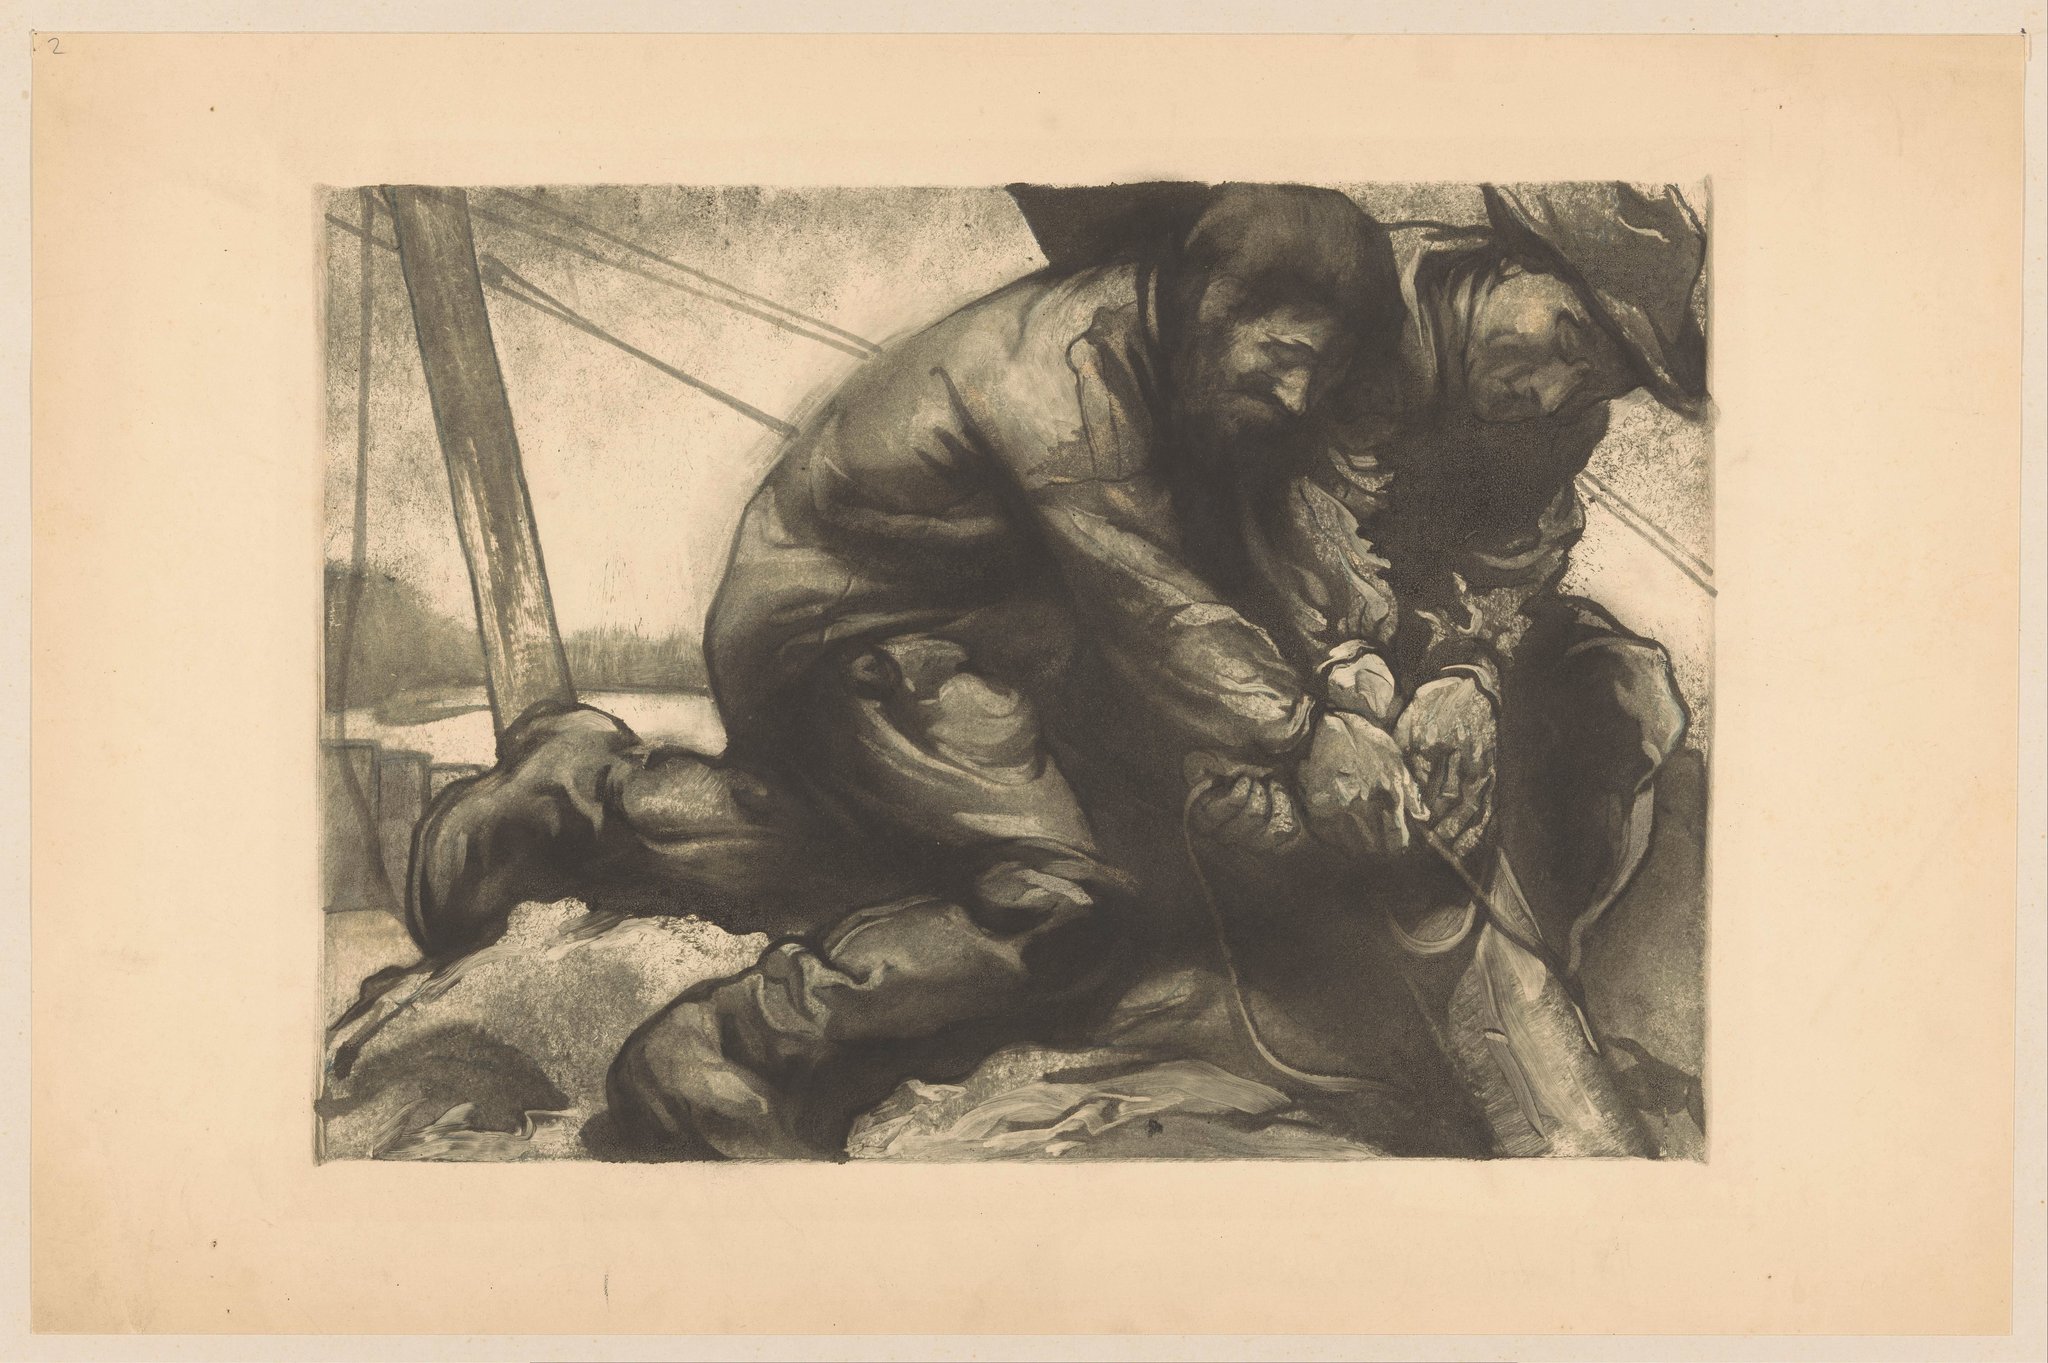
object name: print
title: Twee arbeiders spannen een touw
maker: johannes josephus aarts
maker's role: draughtsman, print maker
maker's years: 1871-1934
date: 1881-1934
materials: paper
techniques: lithograph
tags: working class, labourers, tools, aids, implements ~ crafts and industries: rope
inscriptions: collector's mark: Lugt 2228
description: Twee mannen in werkkleding, waarvan één met hoed, spannen knielend een touw om een paal.